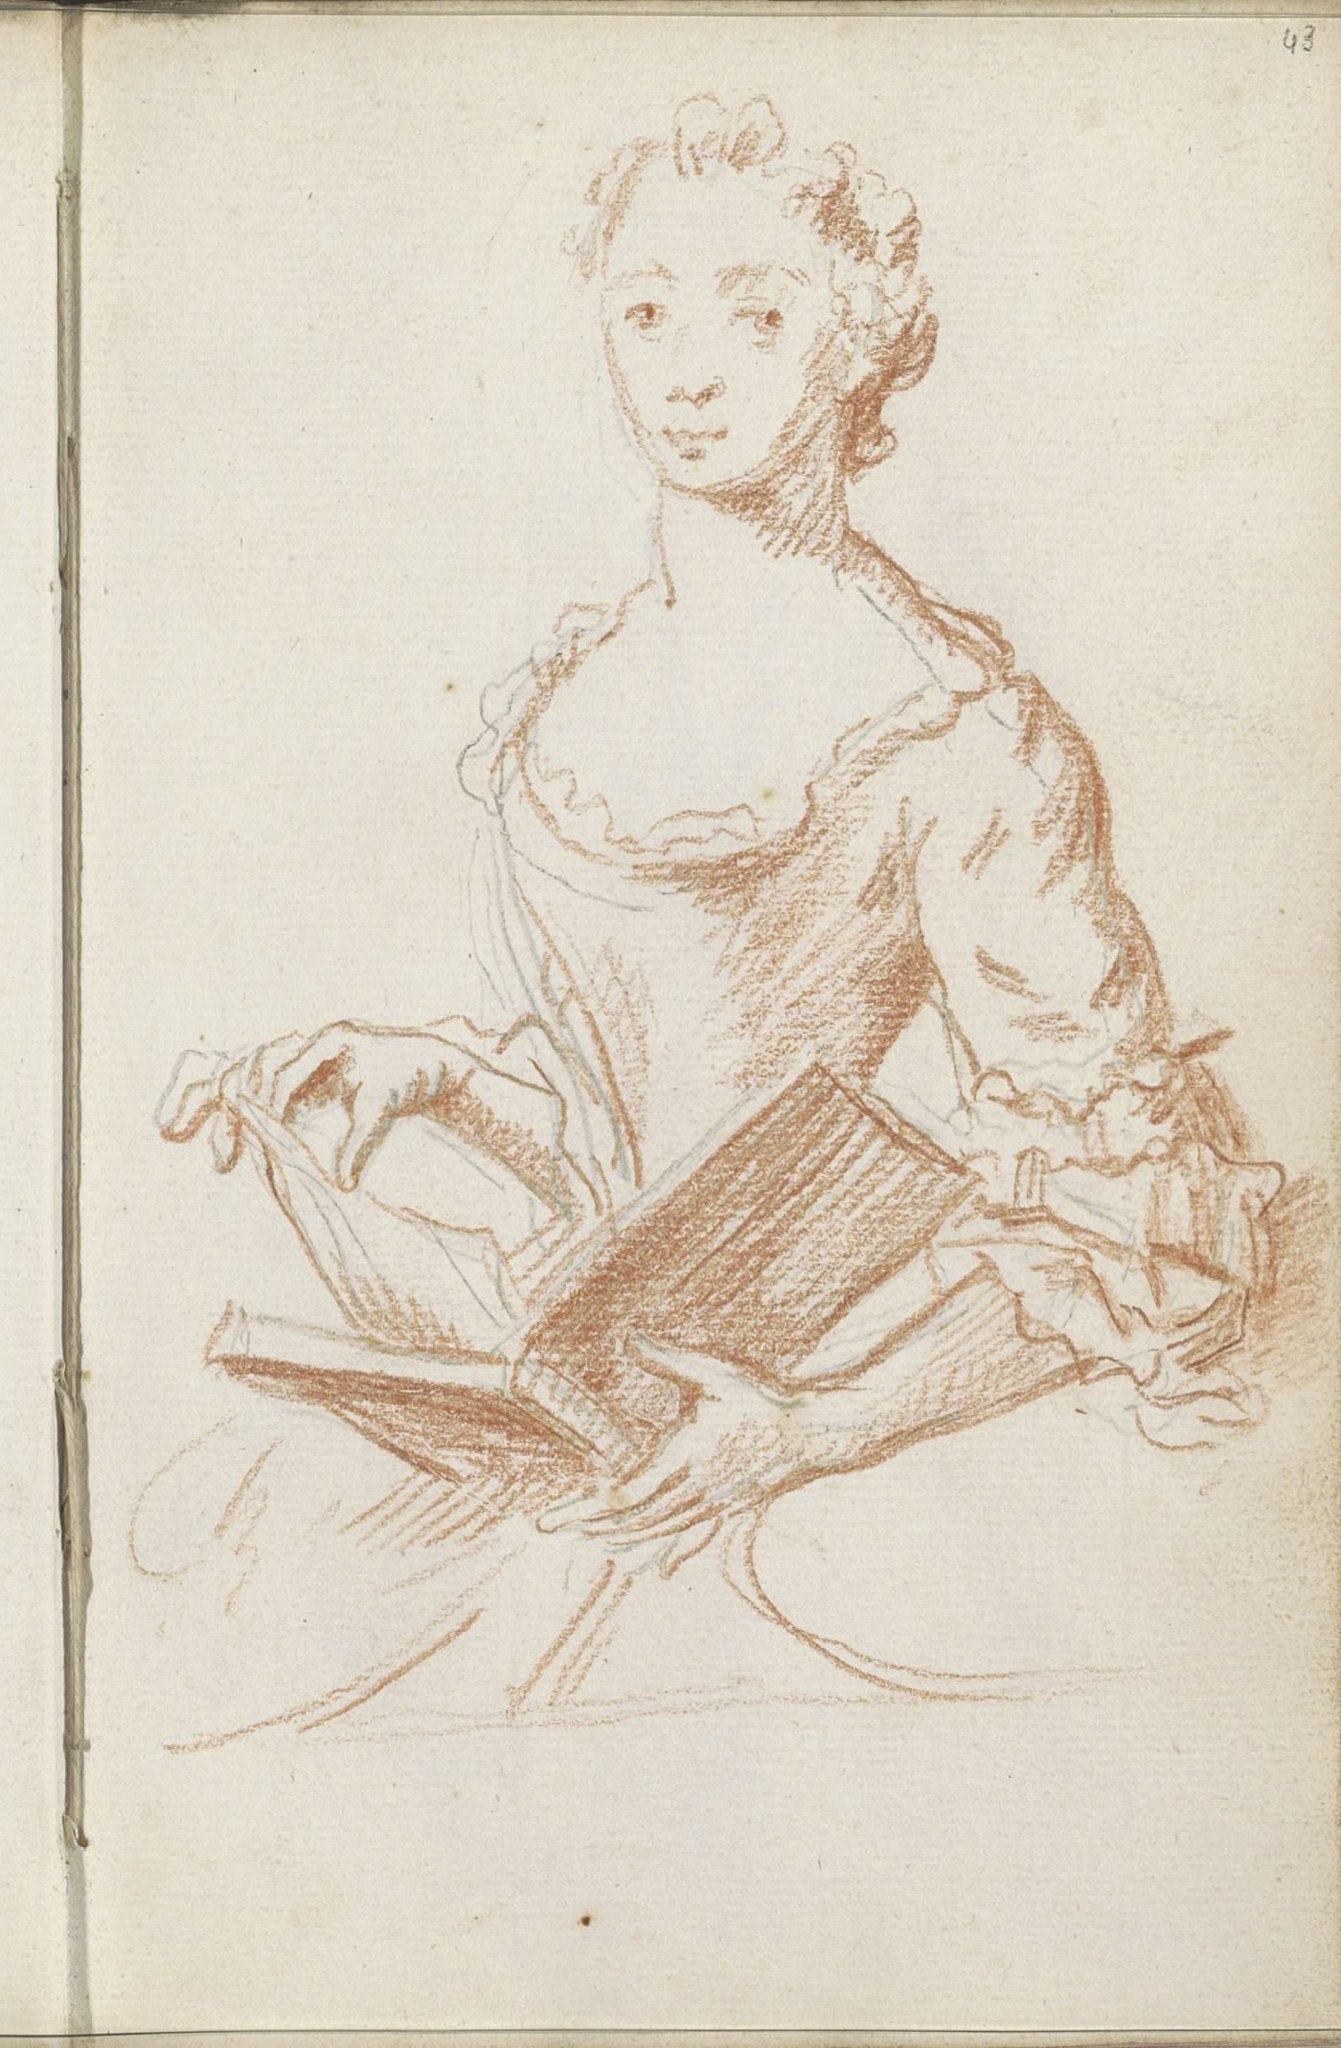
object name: sketchbook leaf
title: Staande vrouw met boek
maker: petrus johannes van reysschoot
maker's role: draughtsman, print maker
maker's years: 1702-1772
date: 1710-1772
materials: chalk, graphite, paper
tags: book, standing figure - aa - female human figure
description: Blad 43 recto uit een schetsboek met 105 bladen.